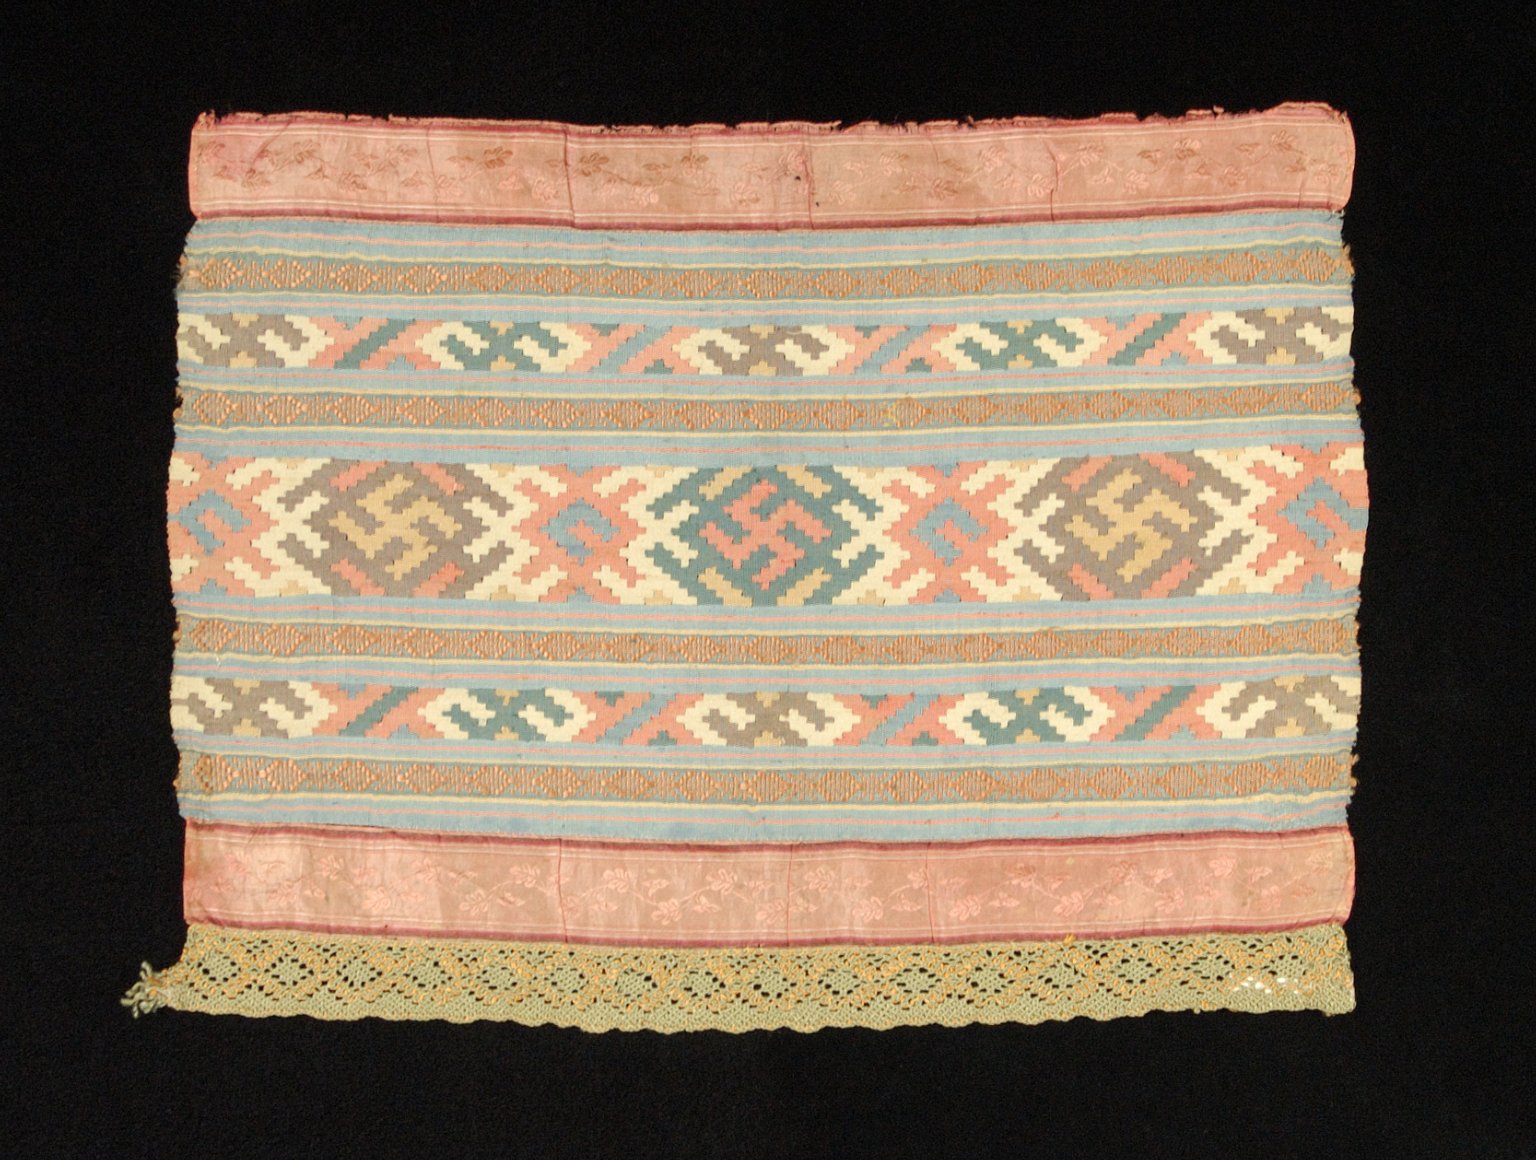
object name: textile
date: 1840-1870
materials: silk